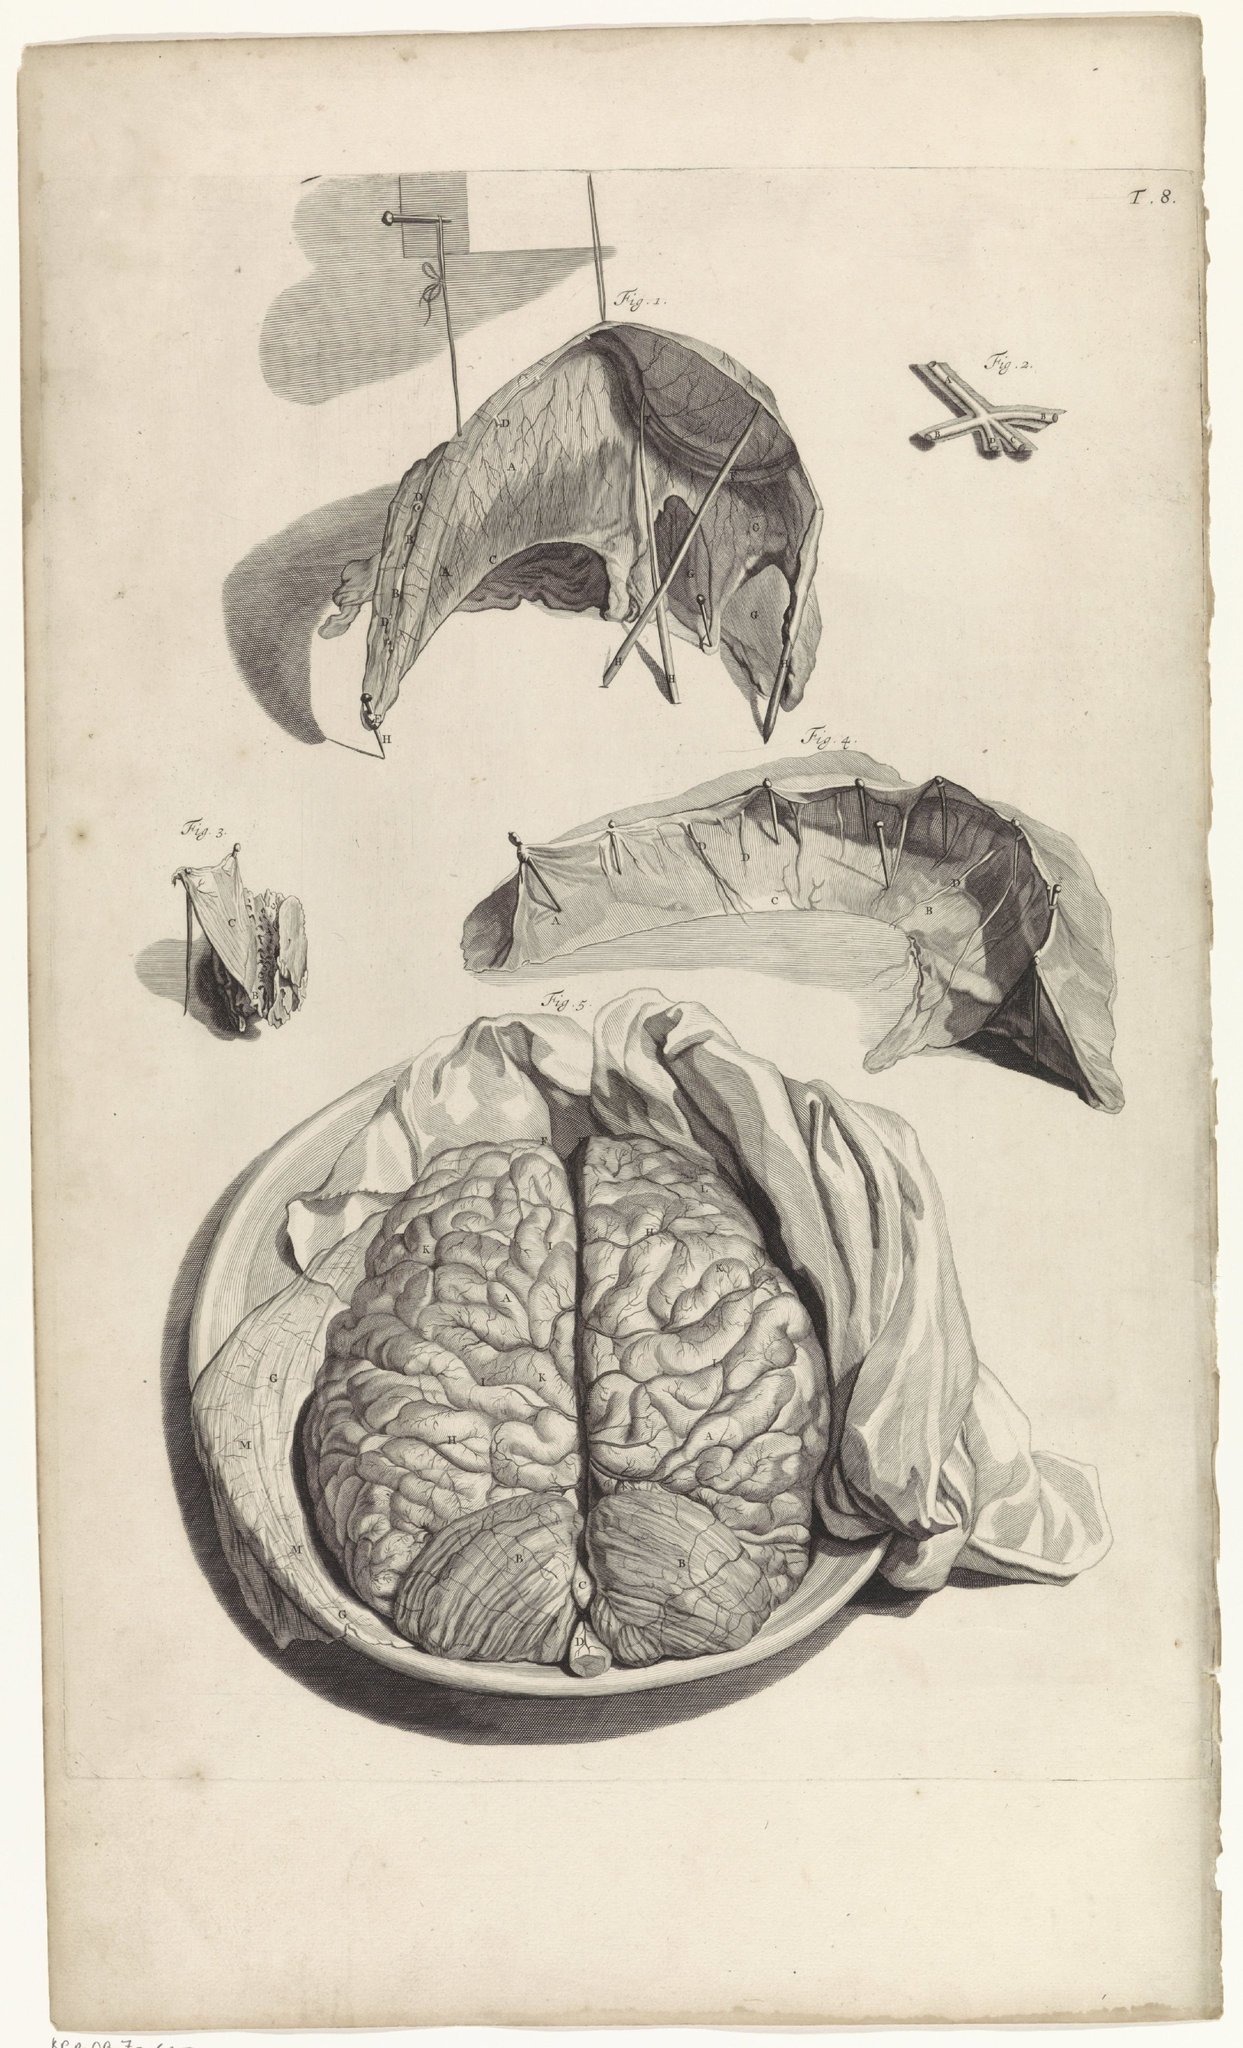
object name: book illustration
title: Anatomische studie van een deel van de schedel en de hersenen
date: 1685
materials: paper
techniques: engraving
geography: amsterdam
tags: brains, (human) skull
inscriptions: collector's mark: Lugt 2228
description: Boekillustratie voor Bidloo, Godefridus. Anatomia humani corporis centum & quinque tabulis, per art. G. de Lairesse ad vivum delineatis, de monstrata, veterum recentiorumque inventis explicata plurimisque, hactenus non detectis, illustrata. Amsterdam: Weduwe Joannes van Someren, Hendrick Boom en erven Dirk Boom, 1685.